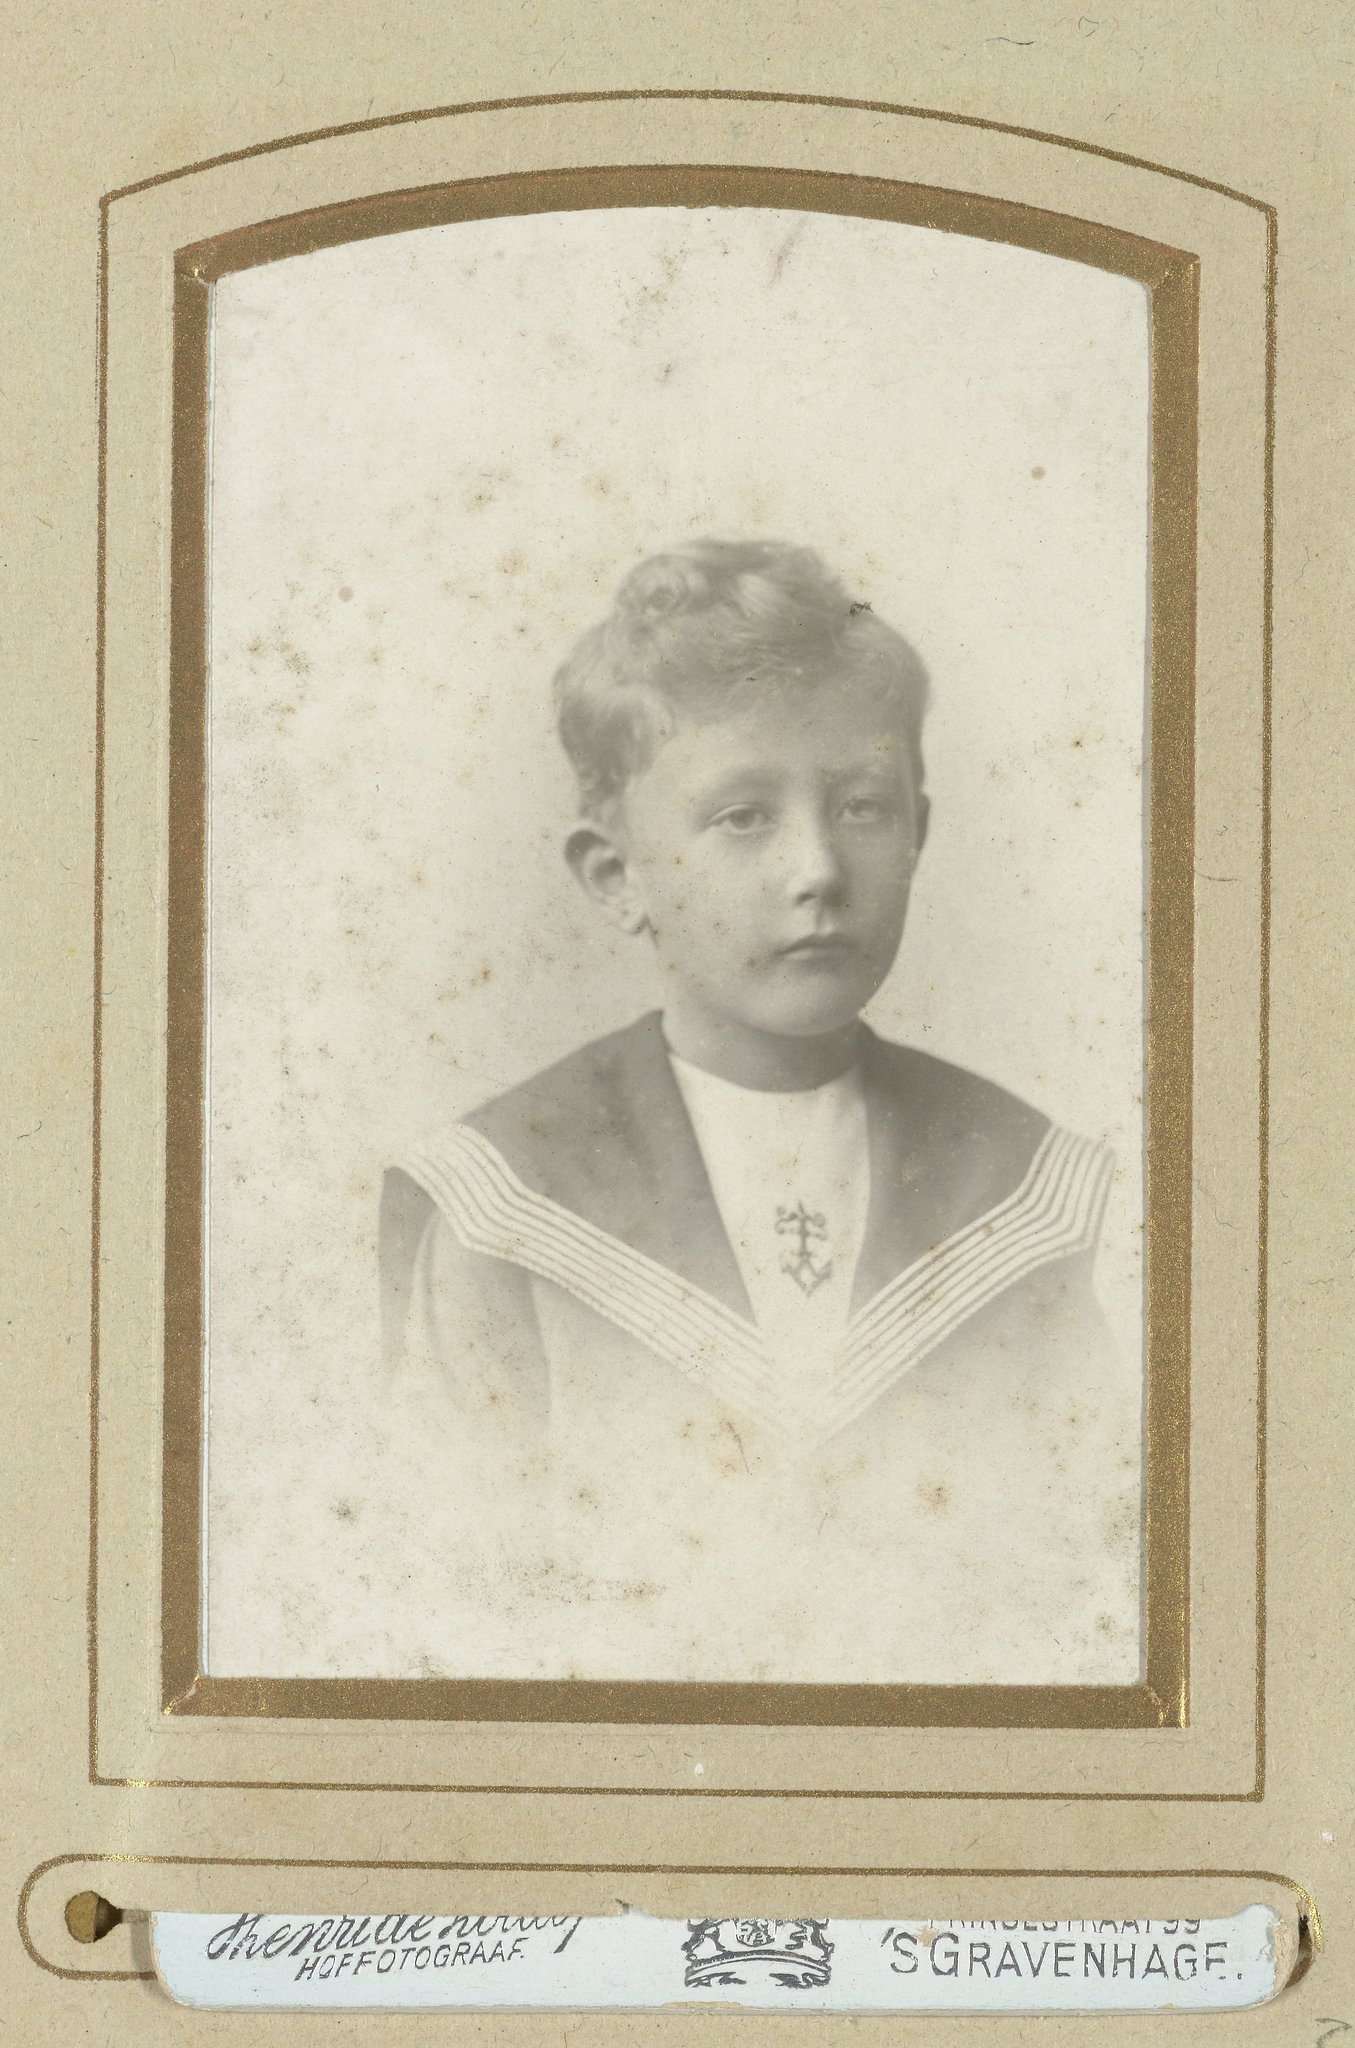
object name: photograph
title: Portret van een jongetje in matrozenpak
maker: henri de louw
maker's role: fotograaf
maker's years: 1851-1944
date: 1890-1910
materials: paper, photographic support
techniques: photography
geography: the hague